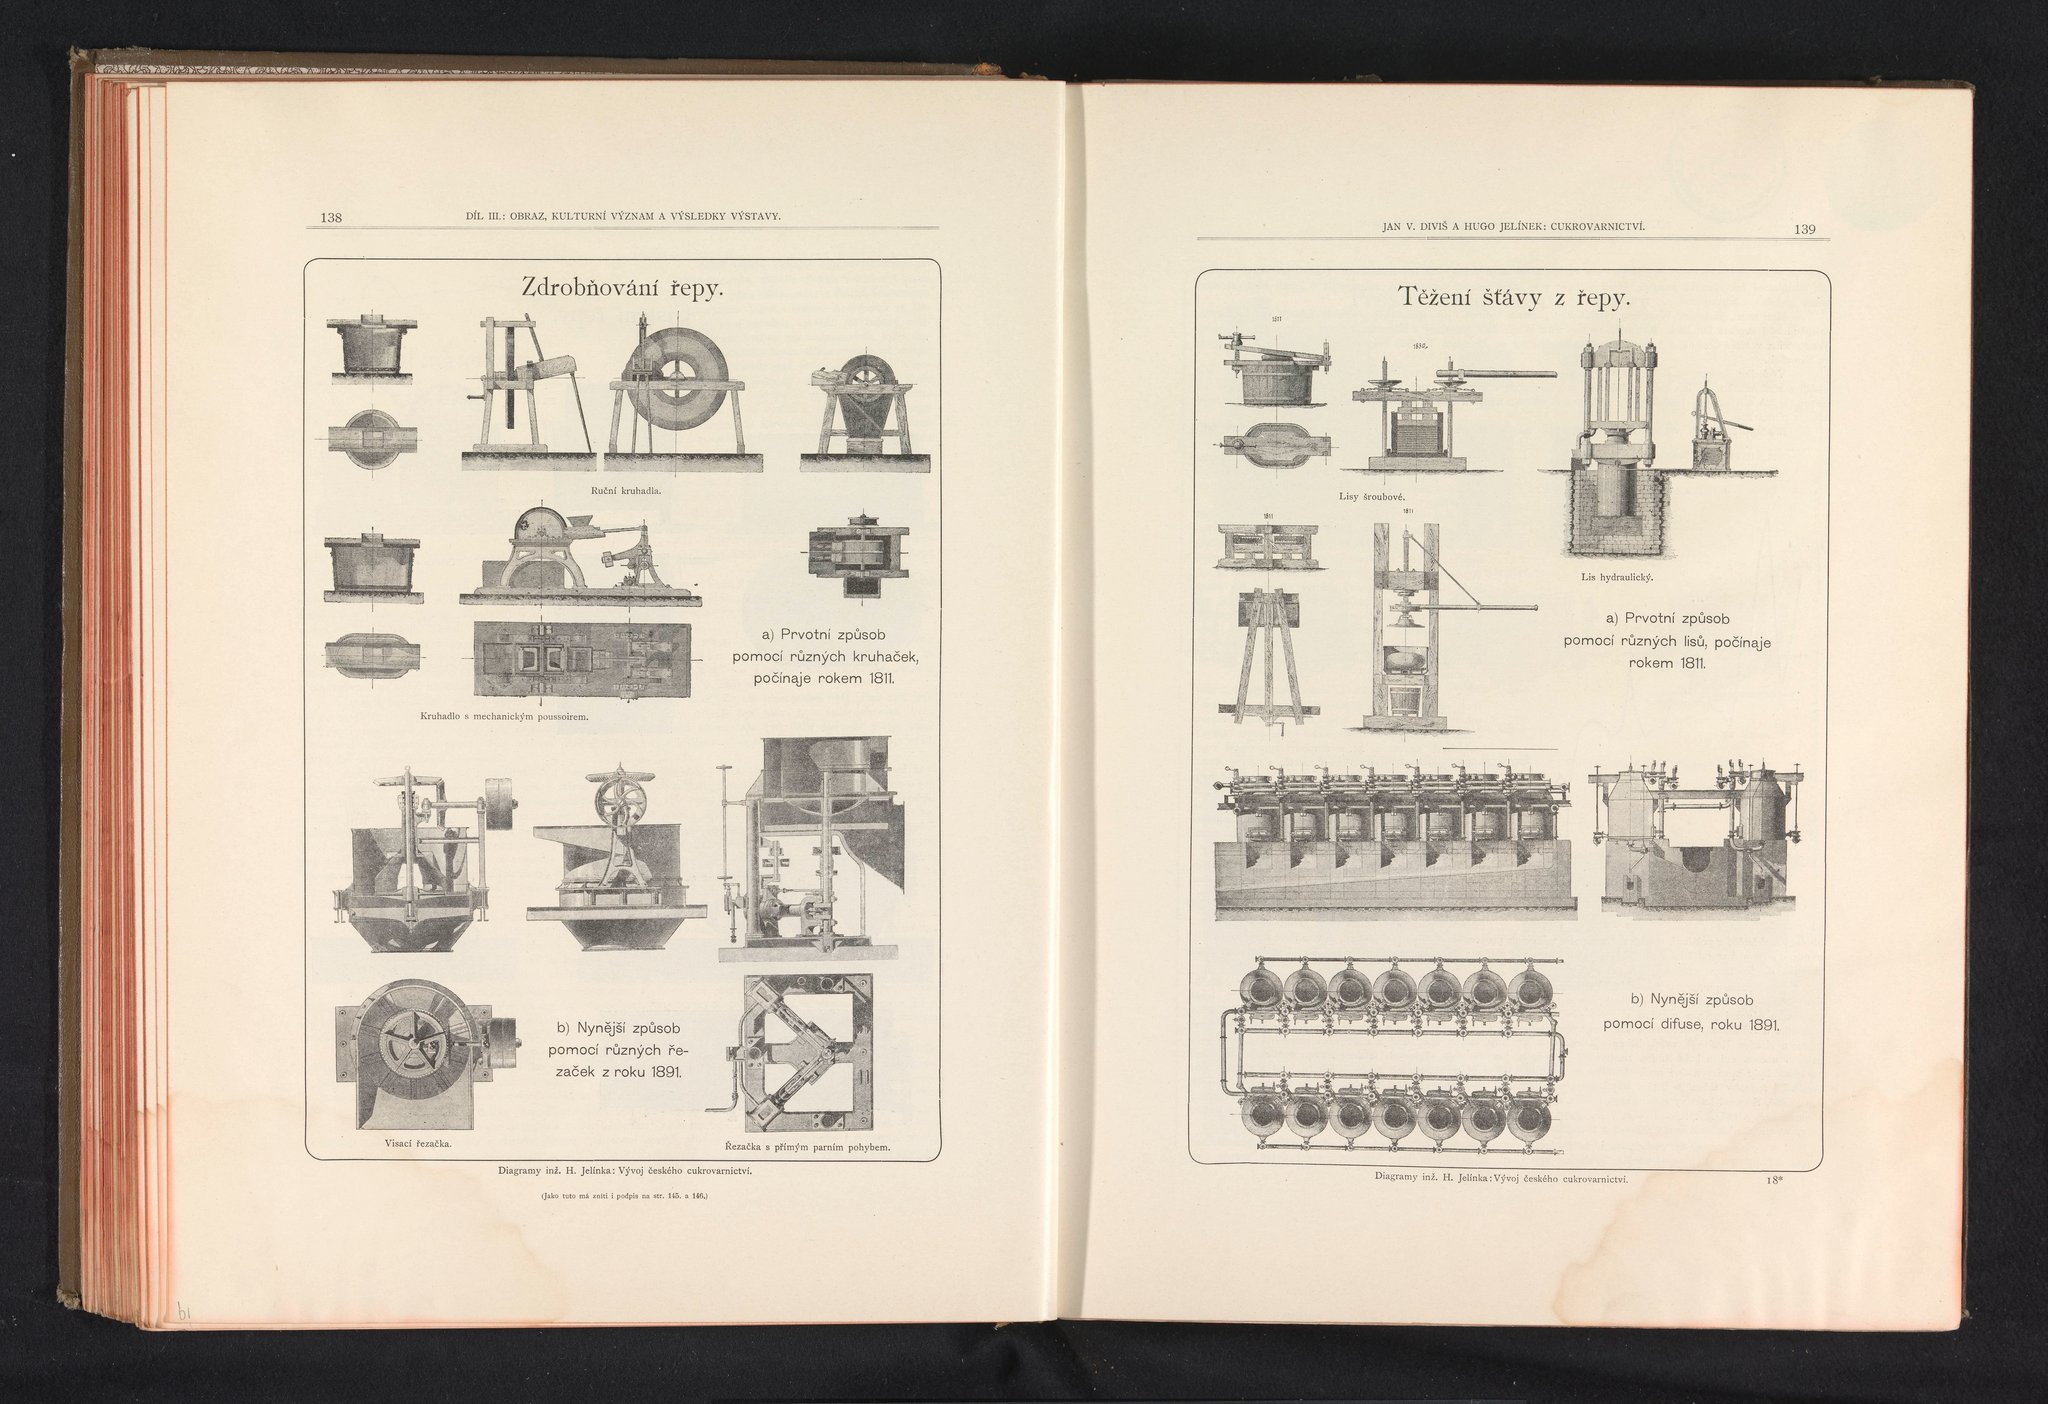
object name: page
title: Zdrobnováni repy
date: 1891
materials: paper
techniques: autotype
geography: prague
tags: machines; parts of machines; tools and appliances